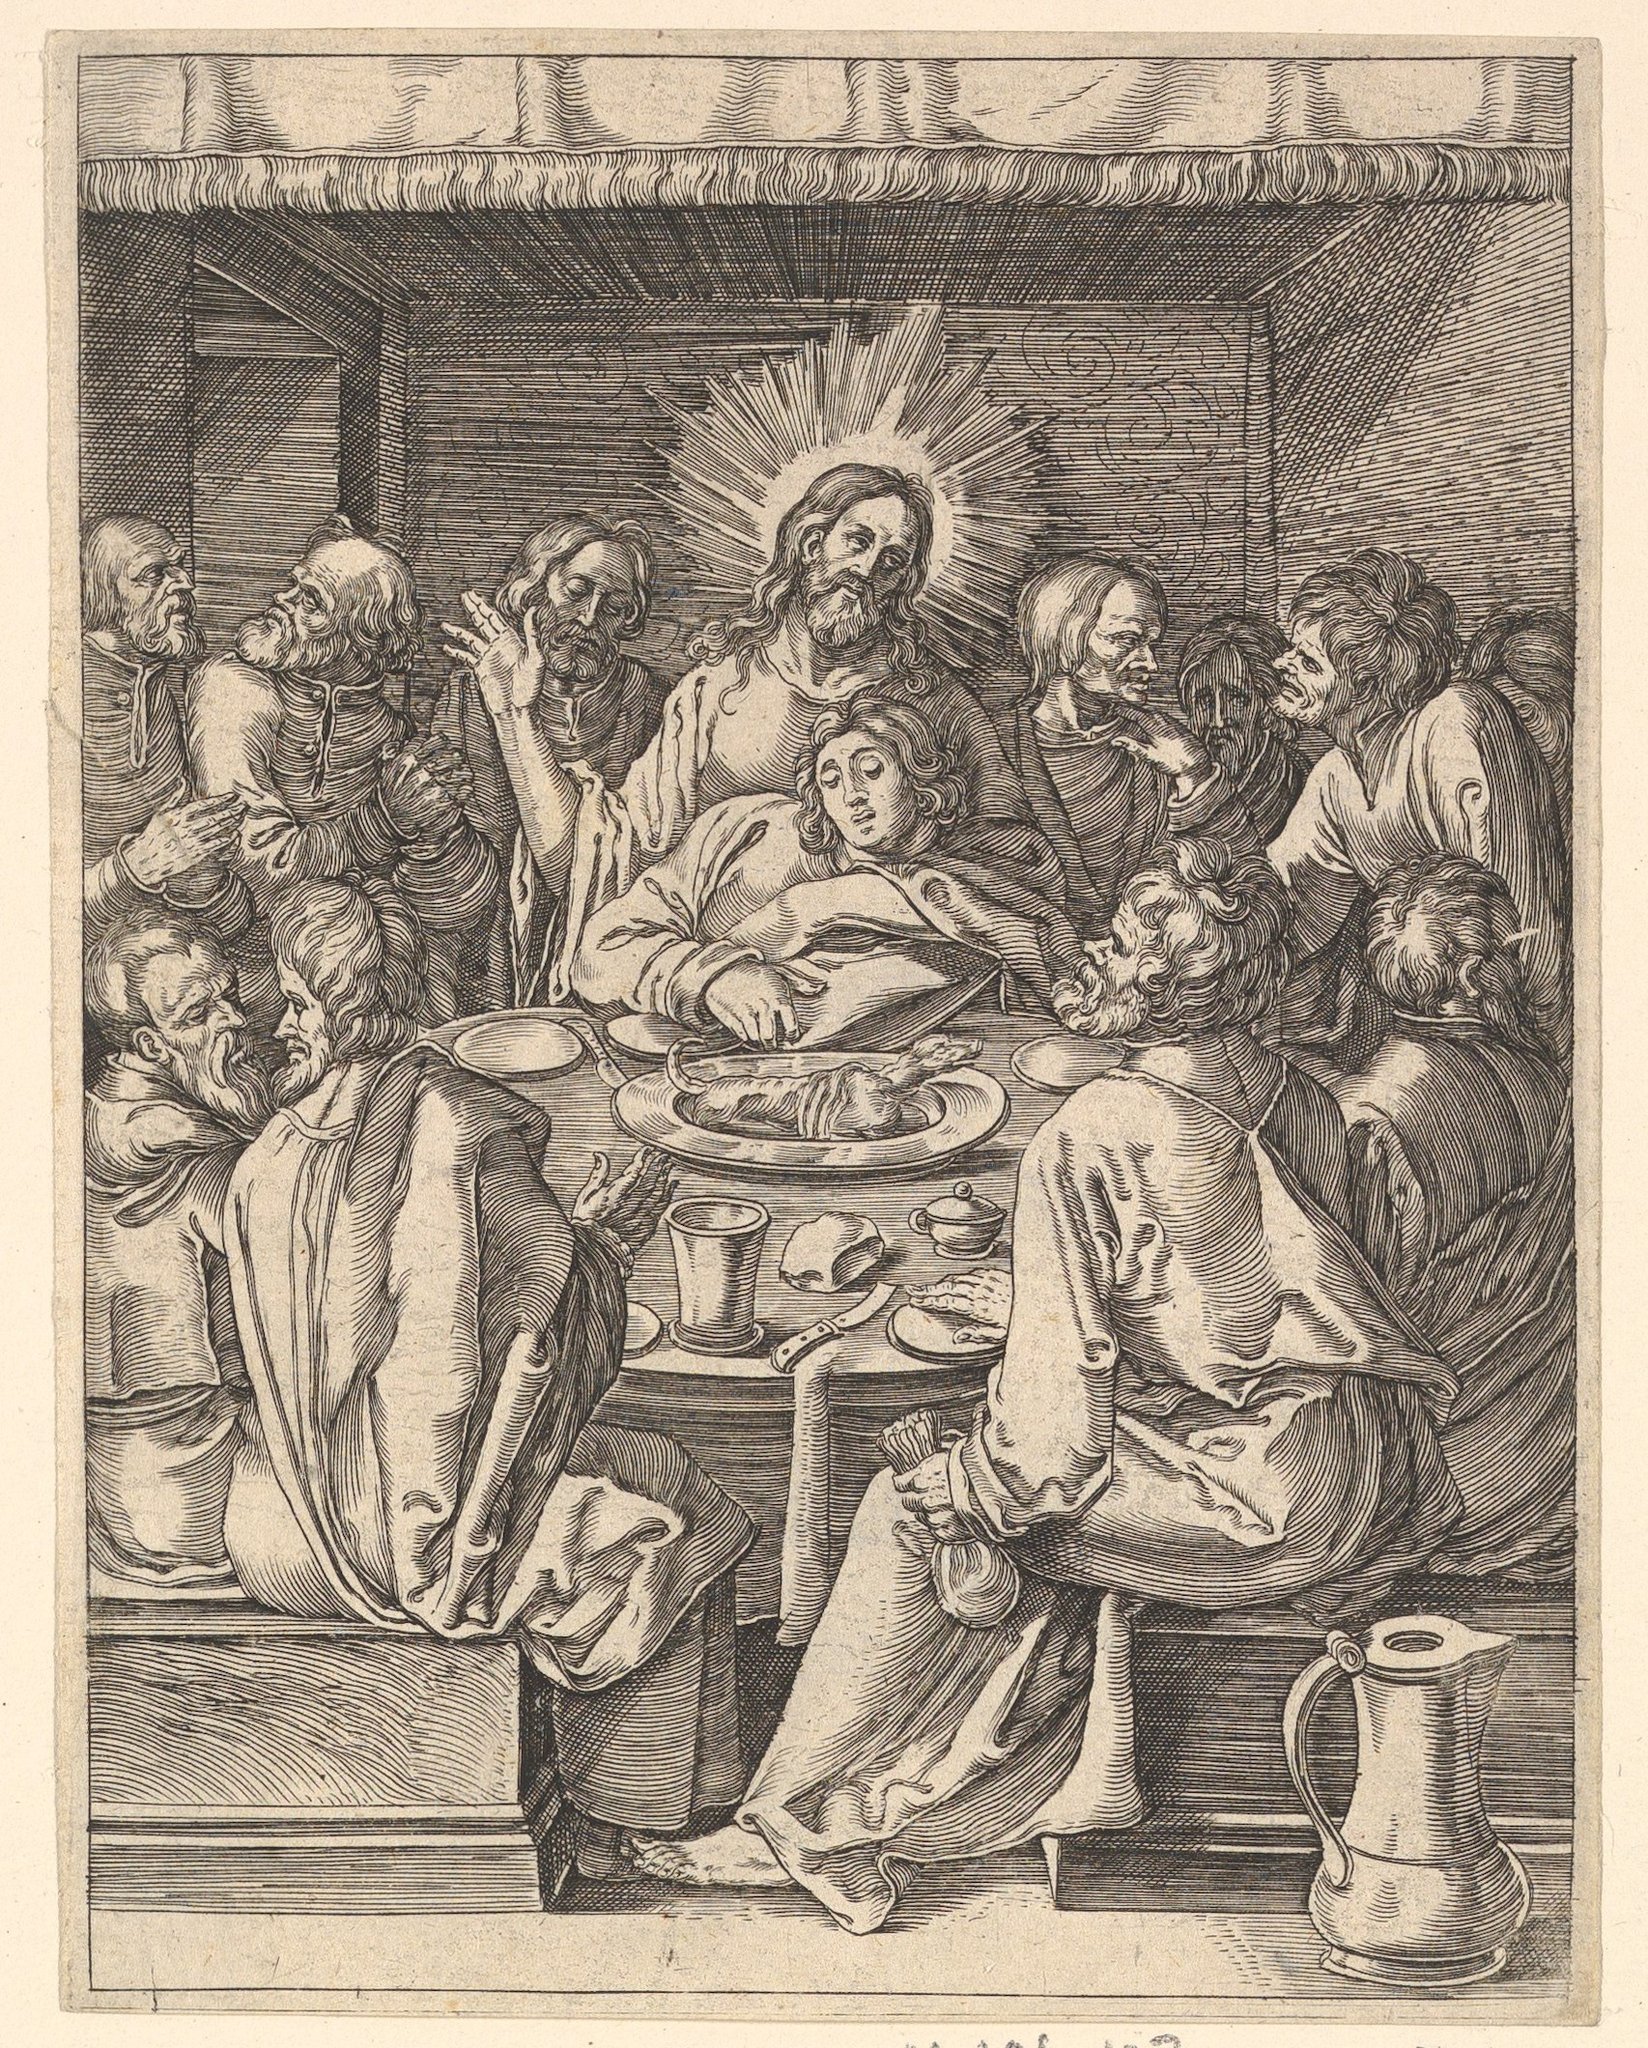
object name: print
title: Engraved copies of The Little Passion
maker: albrecht dürer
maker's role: artist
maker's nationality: german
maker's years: 1471-1528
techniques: engraving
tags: men,christ,dining